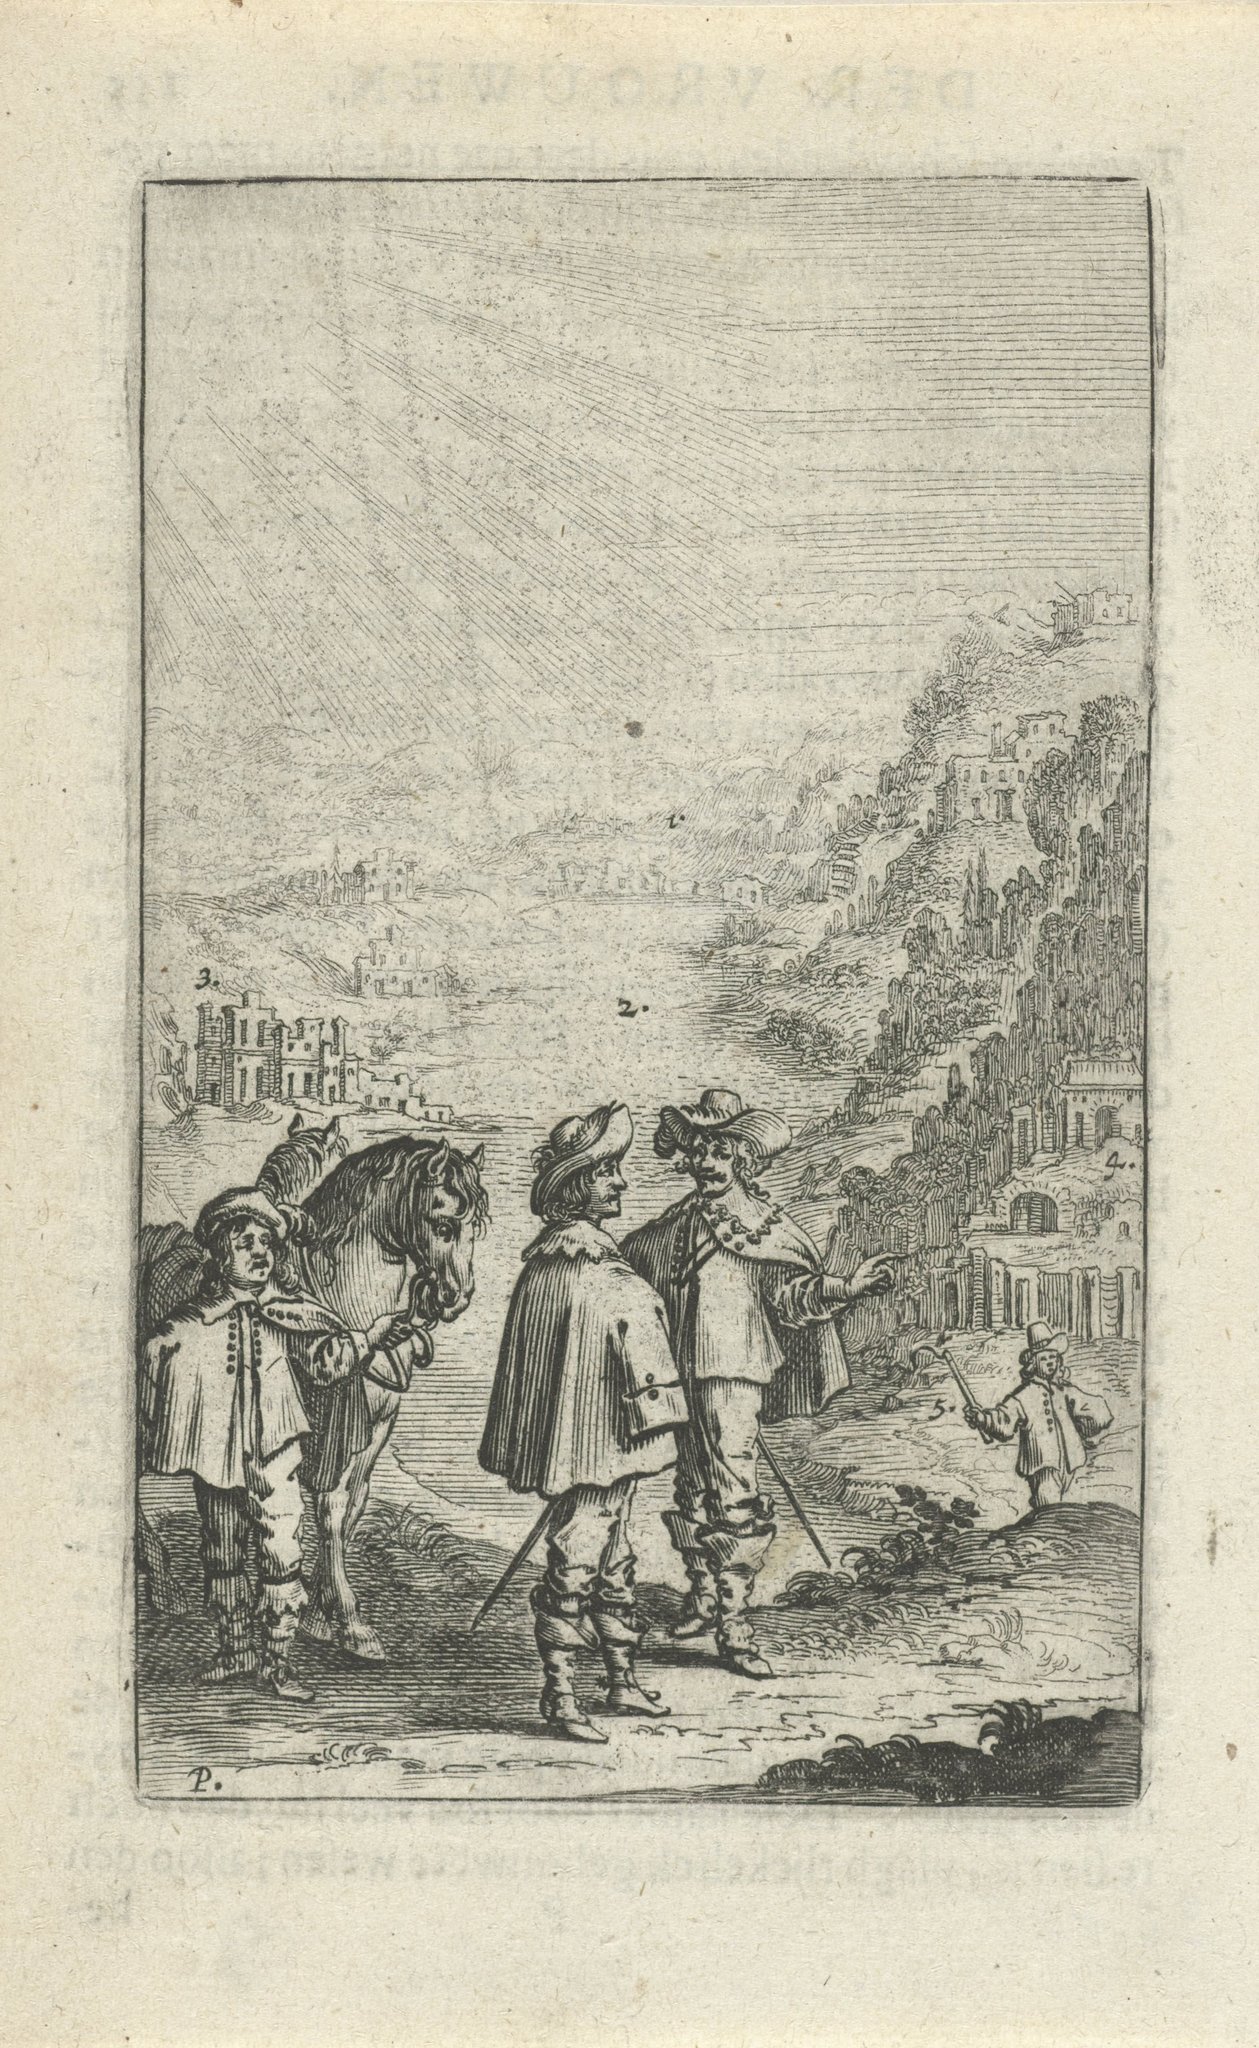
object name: print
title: Ruiters in een berglandschap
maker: paulus lesire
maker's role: print maker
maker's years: 1611-1656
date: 1643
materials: paper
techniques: etching, letterpress printing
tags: riding a horse, ass, or mule; rider, horseman, conversation, dialogue; conversation piece, mountains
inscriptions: collector's mark: Lugt 2760, collector's mark: Lugt 2228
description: Illustratie opgenomen in: Beverwyck, Johannes van. Van de wtnementheyt des vrouwelicken geslachts. Dordrecht: Hendrick van Esch voor Jasper Goris, 1643.